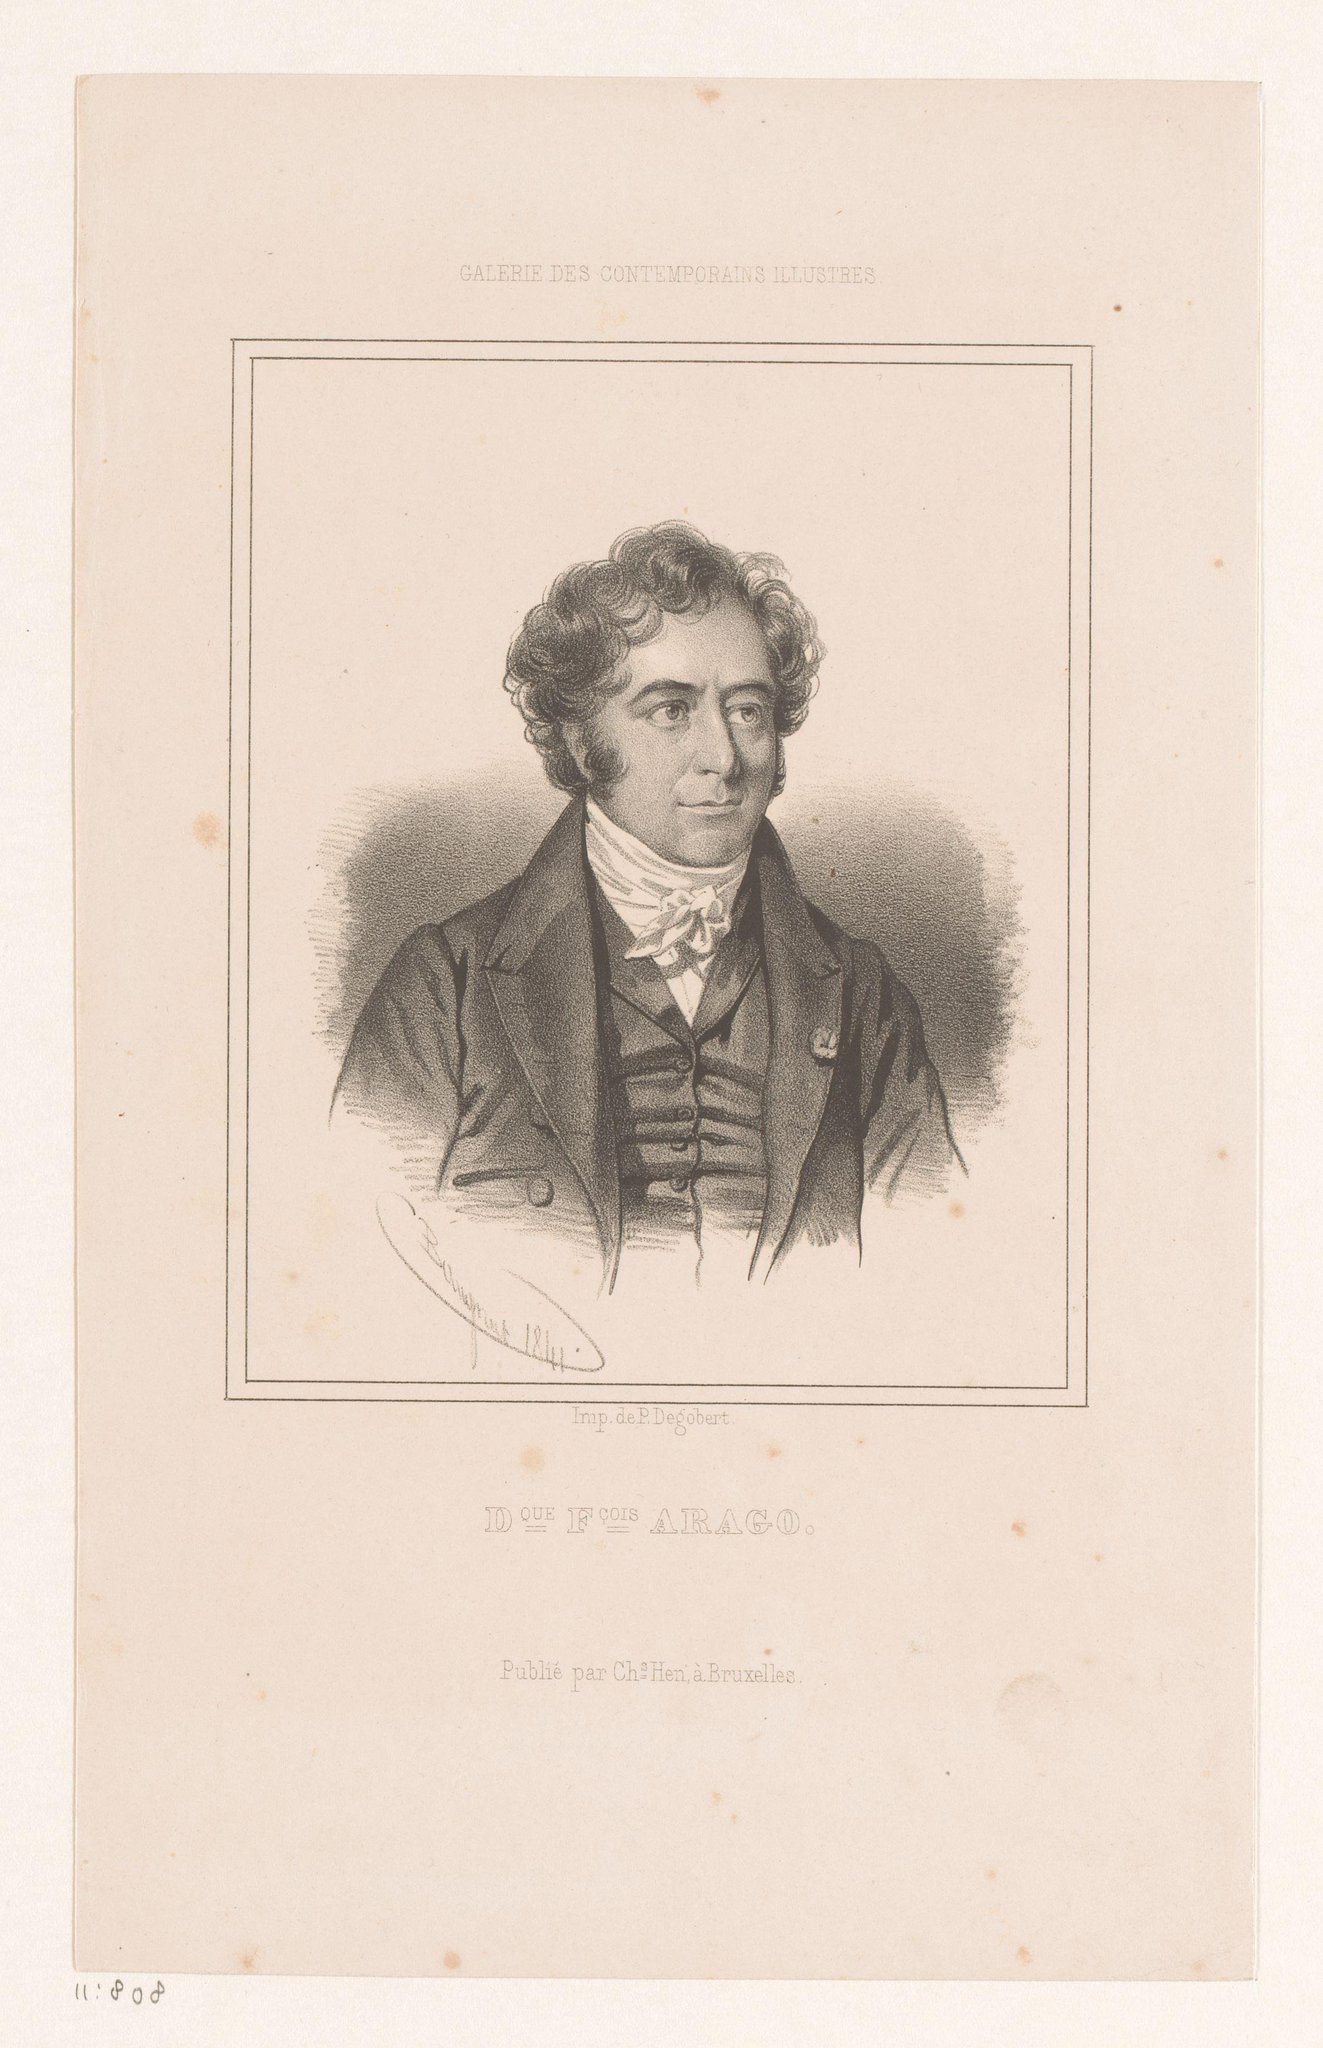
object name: print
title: Portret van François Arago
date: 1841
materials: paper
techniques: lithograph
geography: brussels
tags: paris, adult man, historical persons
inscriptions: collector's mark: Lugt 2228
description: Prent uit: Galerie des contemporains illustres. Brussel: Ch. Hen, 1841.